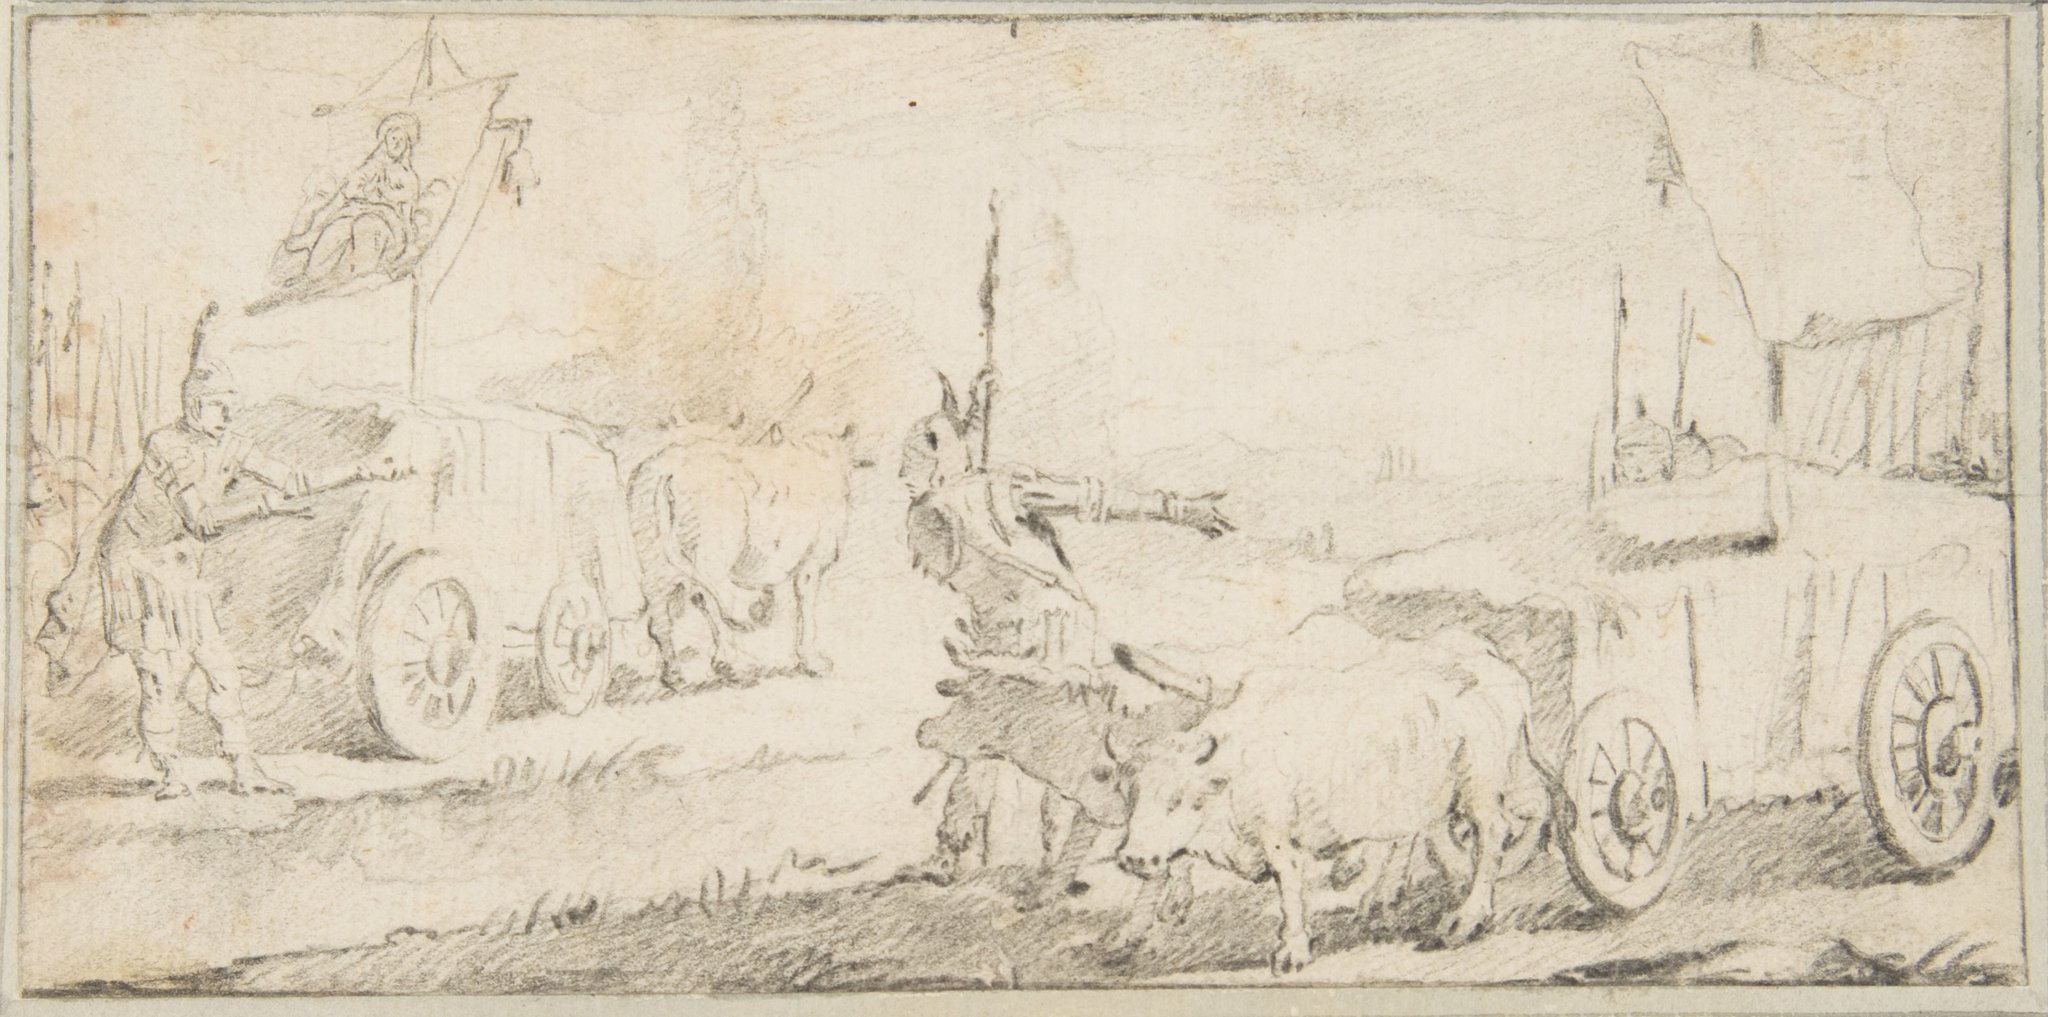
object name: drawing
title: Illustration for a Book: Soldiers Driving Ox Carts with Banners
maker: giovanni battista tiepolo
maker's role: artist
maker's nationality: italian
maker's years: 1696-1770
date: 1696-1770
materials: chalk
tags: soldiers,carts,ox